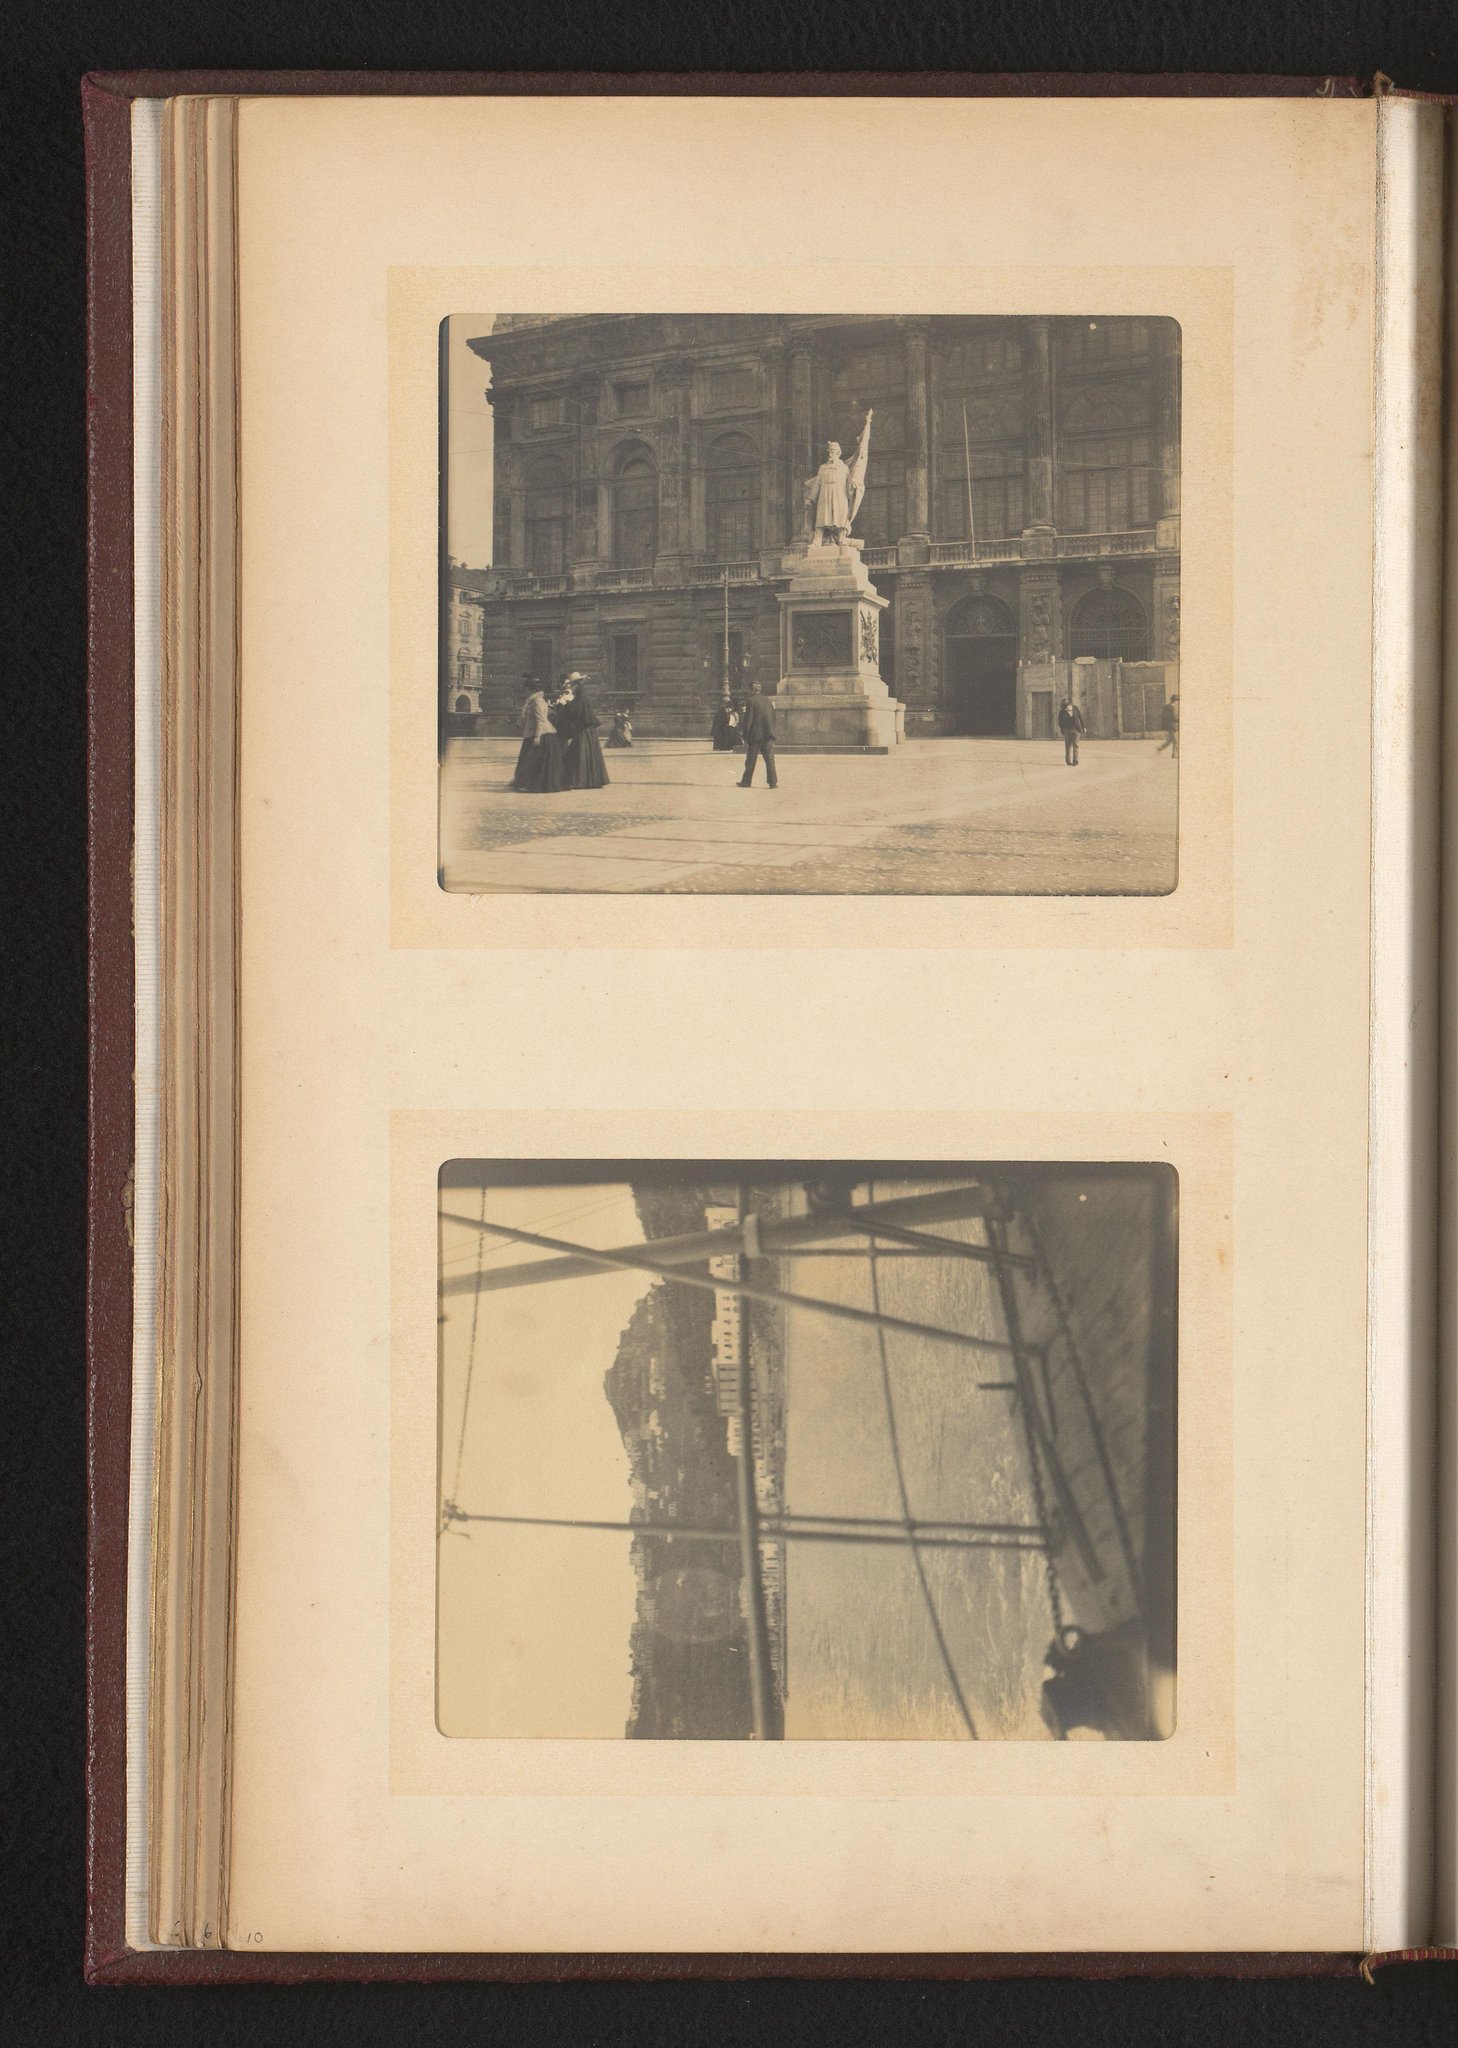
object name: photograph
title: Standbeeld (mogelijk Garibaldi) en gezicht vanaf het water (Genua?)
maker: Anonymous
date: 1895-1905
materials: cardboard, photographic support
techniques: gelatin silver print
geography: genoa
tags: tourism, monument, statue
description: Albumblad met twee foto's, mogelijk van Genua. Onderdeel van een fotoalbum van een reis door Italië, ca. 1900.